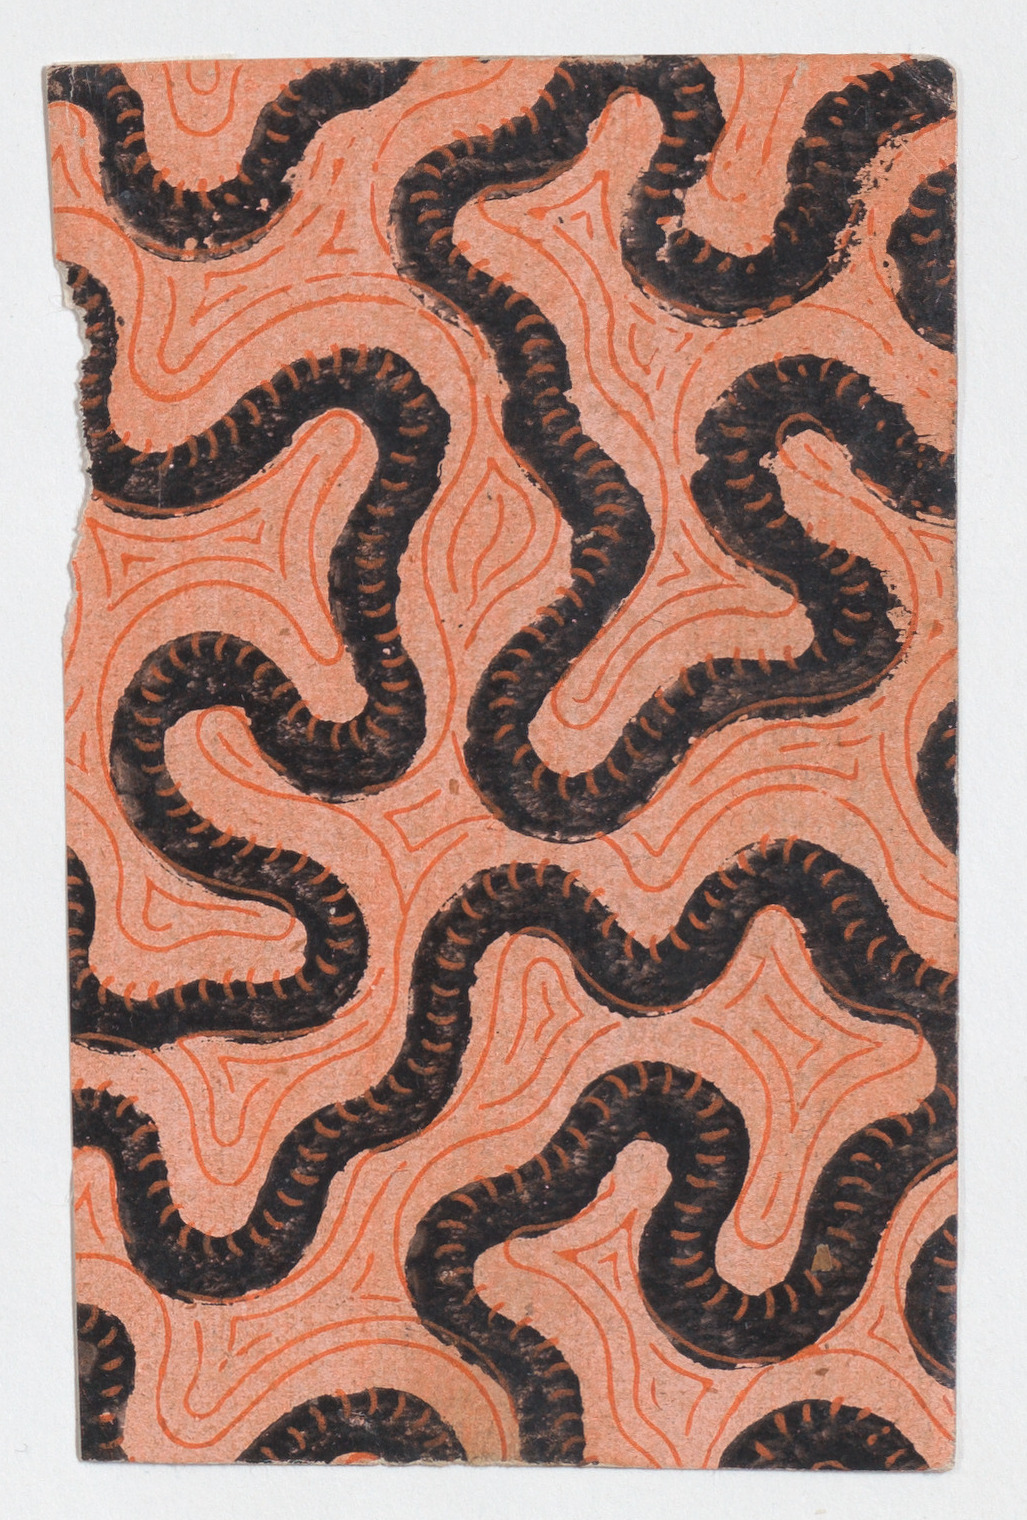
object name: print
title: Sheet with abstract pattern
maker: Anonymous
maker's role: artist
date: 1801-1900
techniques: relief print